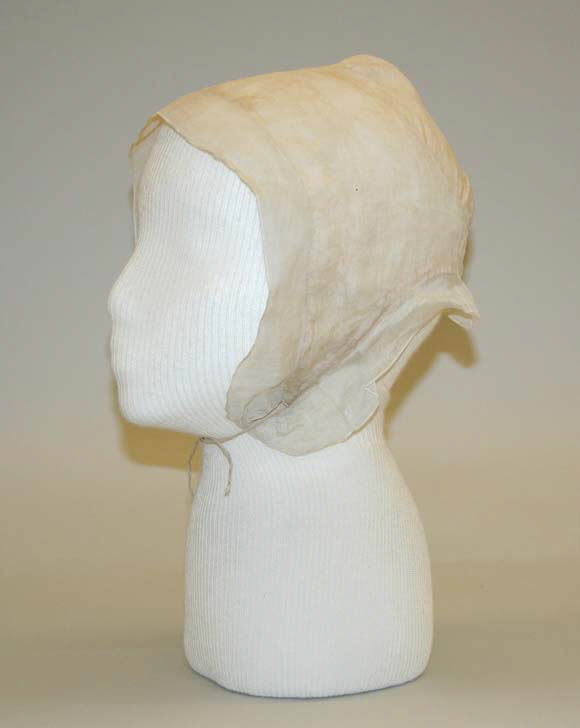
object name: cap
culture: american or european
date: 1730-1749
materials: linen